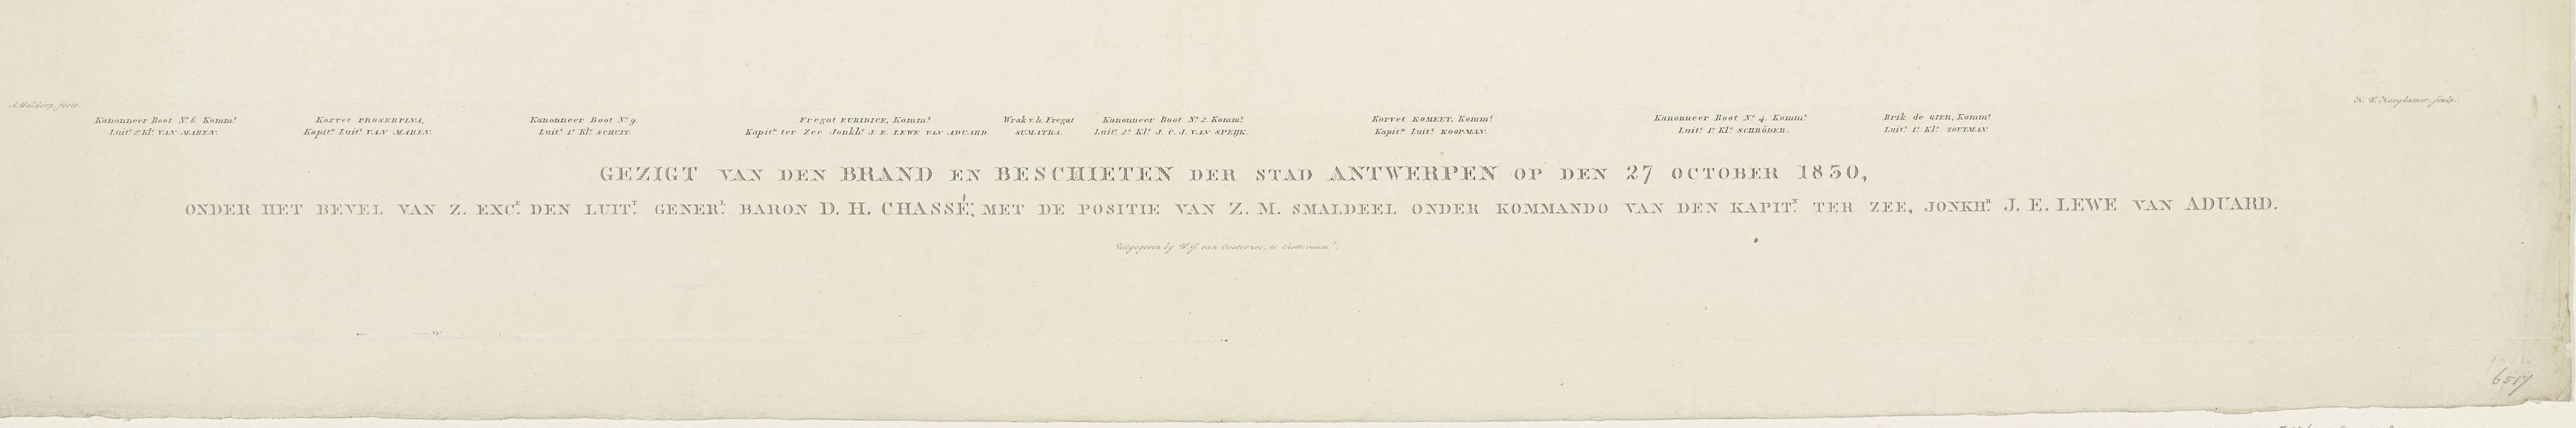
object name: print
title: Gezigt van den Brand en Beschieten der stad Antwerpen op den 27 october 1830, onder het bevel van Z. Exc.e Luit.t Gener.l Baron D.H. Chassé; met de positie van Z.M. Smaldeel onder kommando van den Kapit.n ter Zee, Jonkh.r J.E. Lewe van Aduard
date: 1830-1831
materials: paper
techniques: etching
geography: netherlands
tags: amsterdam, antwerp, jan van speyk, david hendrik baron chassé, bombardment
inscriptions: collector's mark: Lugt 2228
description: Apart blad met een afdruk (met cache) van alleen de tekst met de titel en de namen van de afgebeelde schepen en hun gezagvoerders. Behoort bij de afbeelding van het bombardement van Antwerpen door de Nederlandse oorlogsschepen onder commando van generaal Chassé, vanaf de Schelde, 27 oktober 1830.